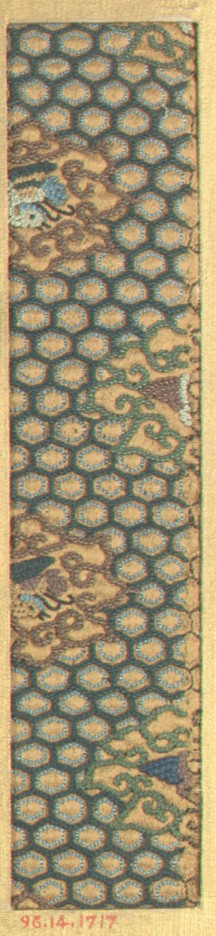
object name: piece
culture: japanese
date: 1701-1900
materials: silk